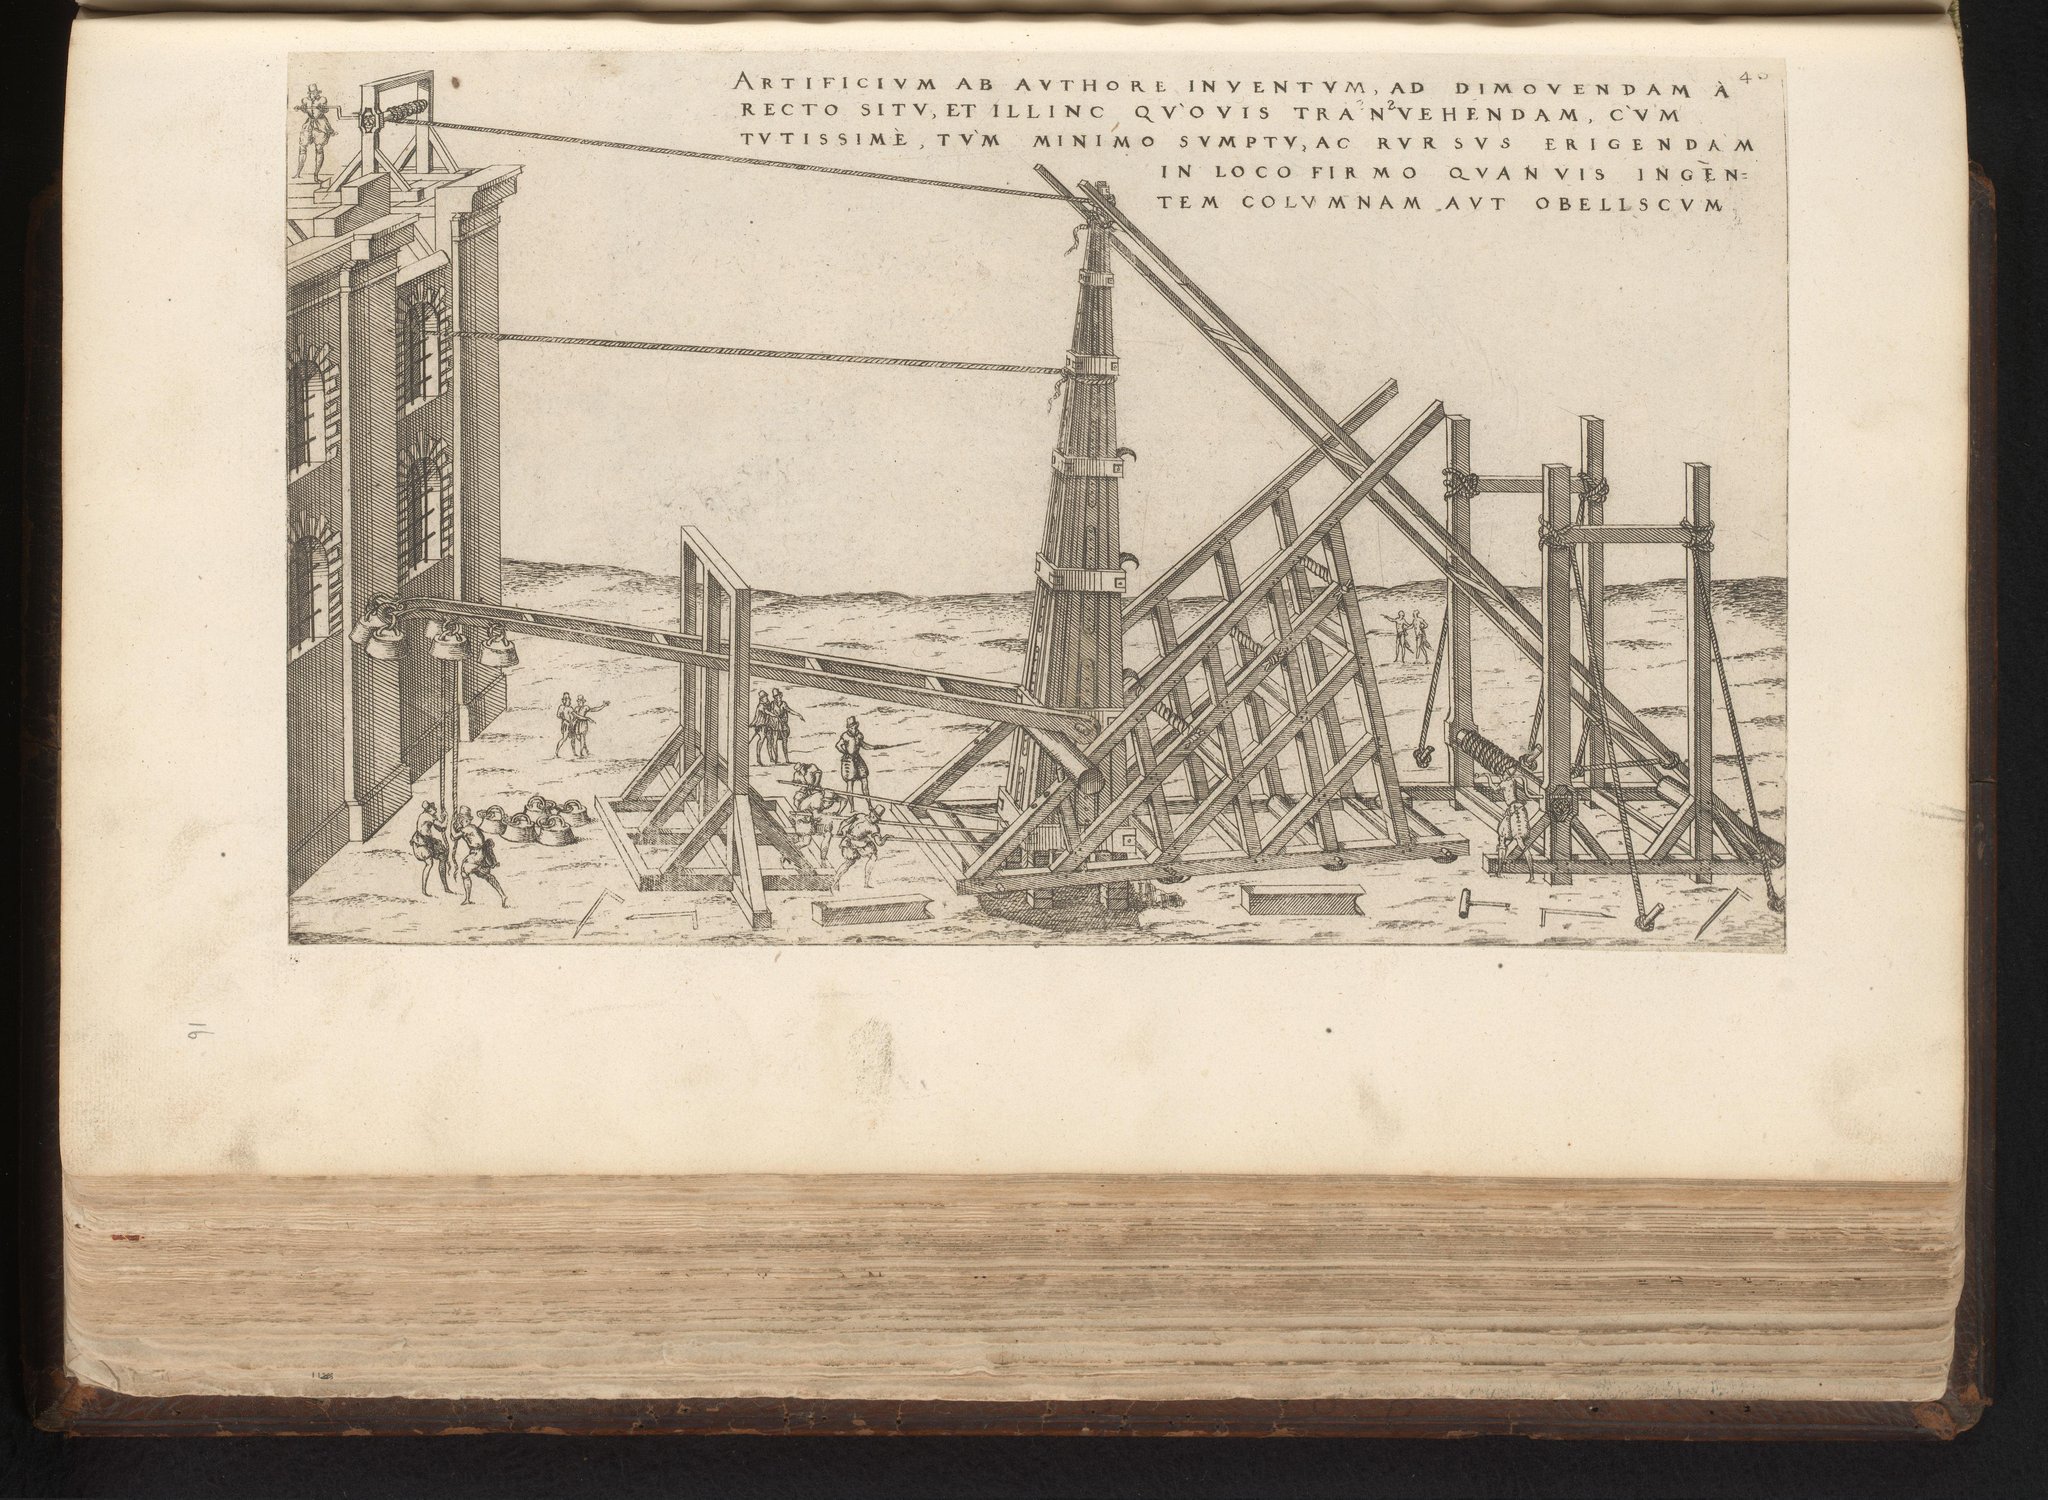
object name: album leaf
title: Houten constructie voor het oprichten van een zuil of obelisk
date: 1579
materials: paper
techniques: etching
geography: lyon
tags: tools and machines ~ building, obelisk, needle, column, pillar ~ architecture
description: Prent uit: Besson, Jacques. Theatre des instrumens mathematiques & mechaniques. Lyon: Barthelemy Vincent, 1579. Prent voor het eerst verschenen in de eerste editie van ca. 1569.